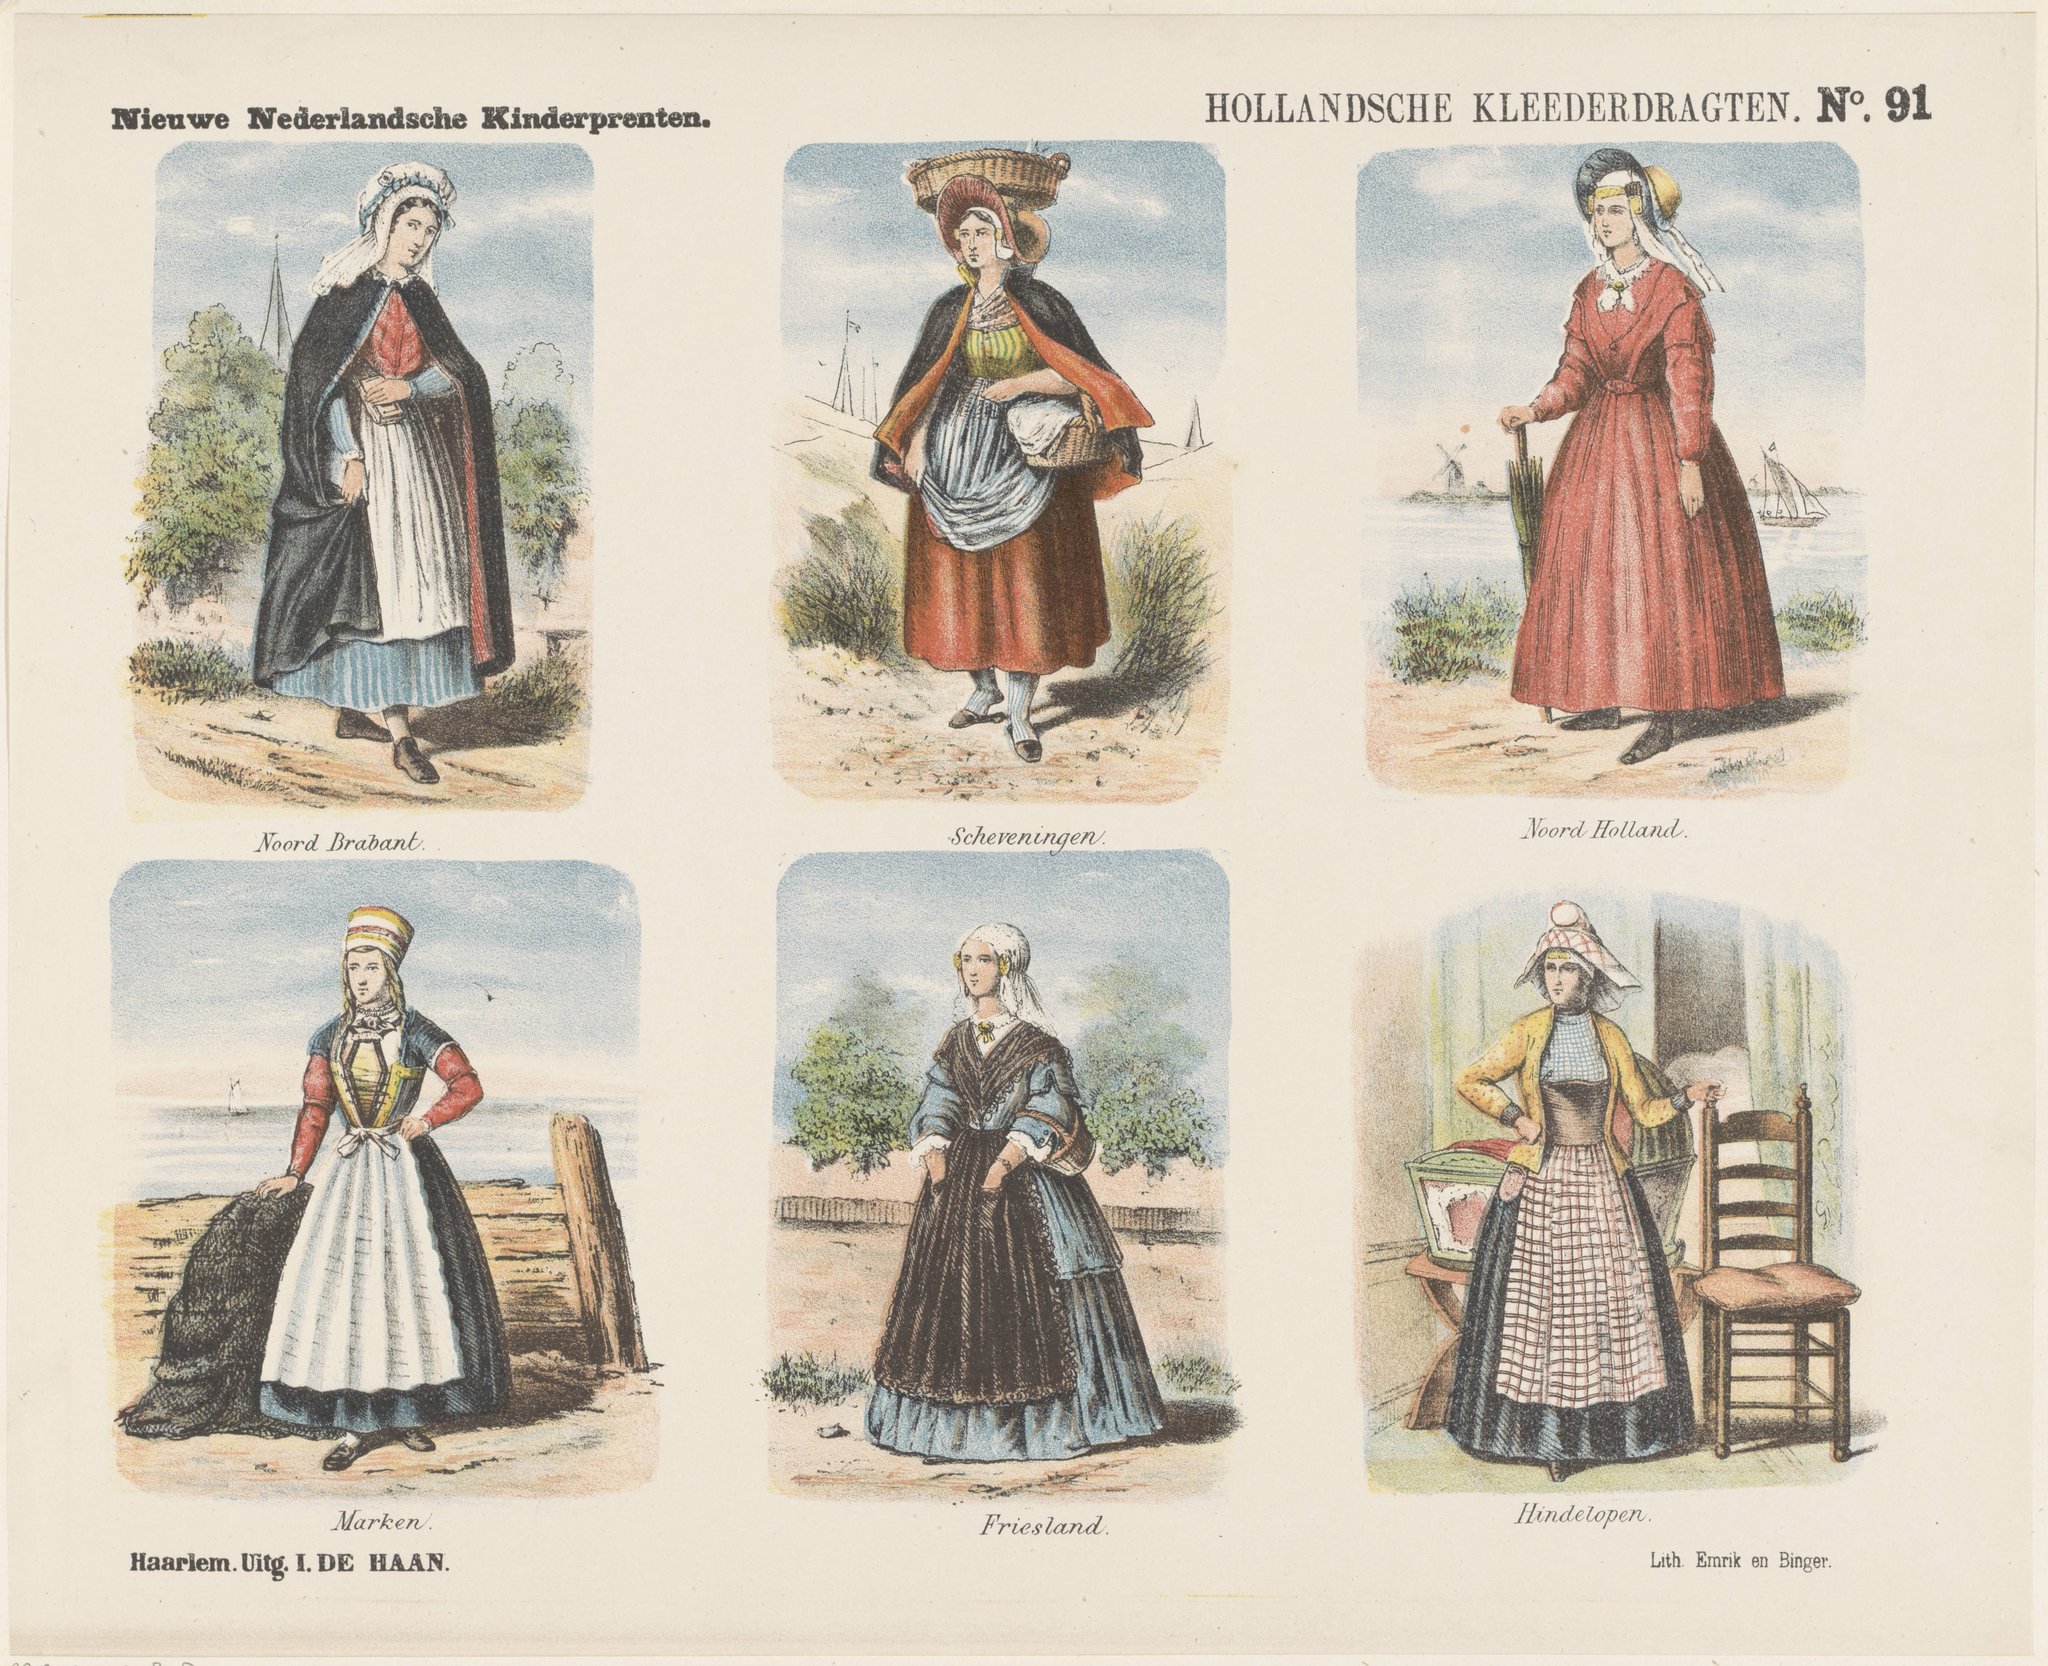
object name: popular print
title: Hollandsche kleederdragten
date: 1875-1903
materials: paper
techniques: lithograph, letterpress printing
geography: haarlem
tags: historical costume, folk costume, regional costume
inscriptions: collector's mark: Lugt 2760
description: Blad met 6 voorstellingen van vrouwen in verschillende Nederlandse klederdrachten. Onder elke afbeelding een onderschrift. Genummerd rechtsboven: No. 91.